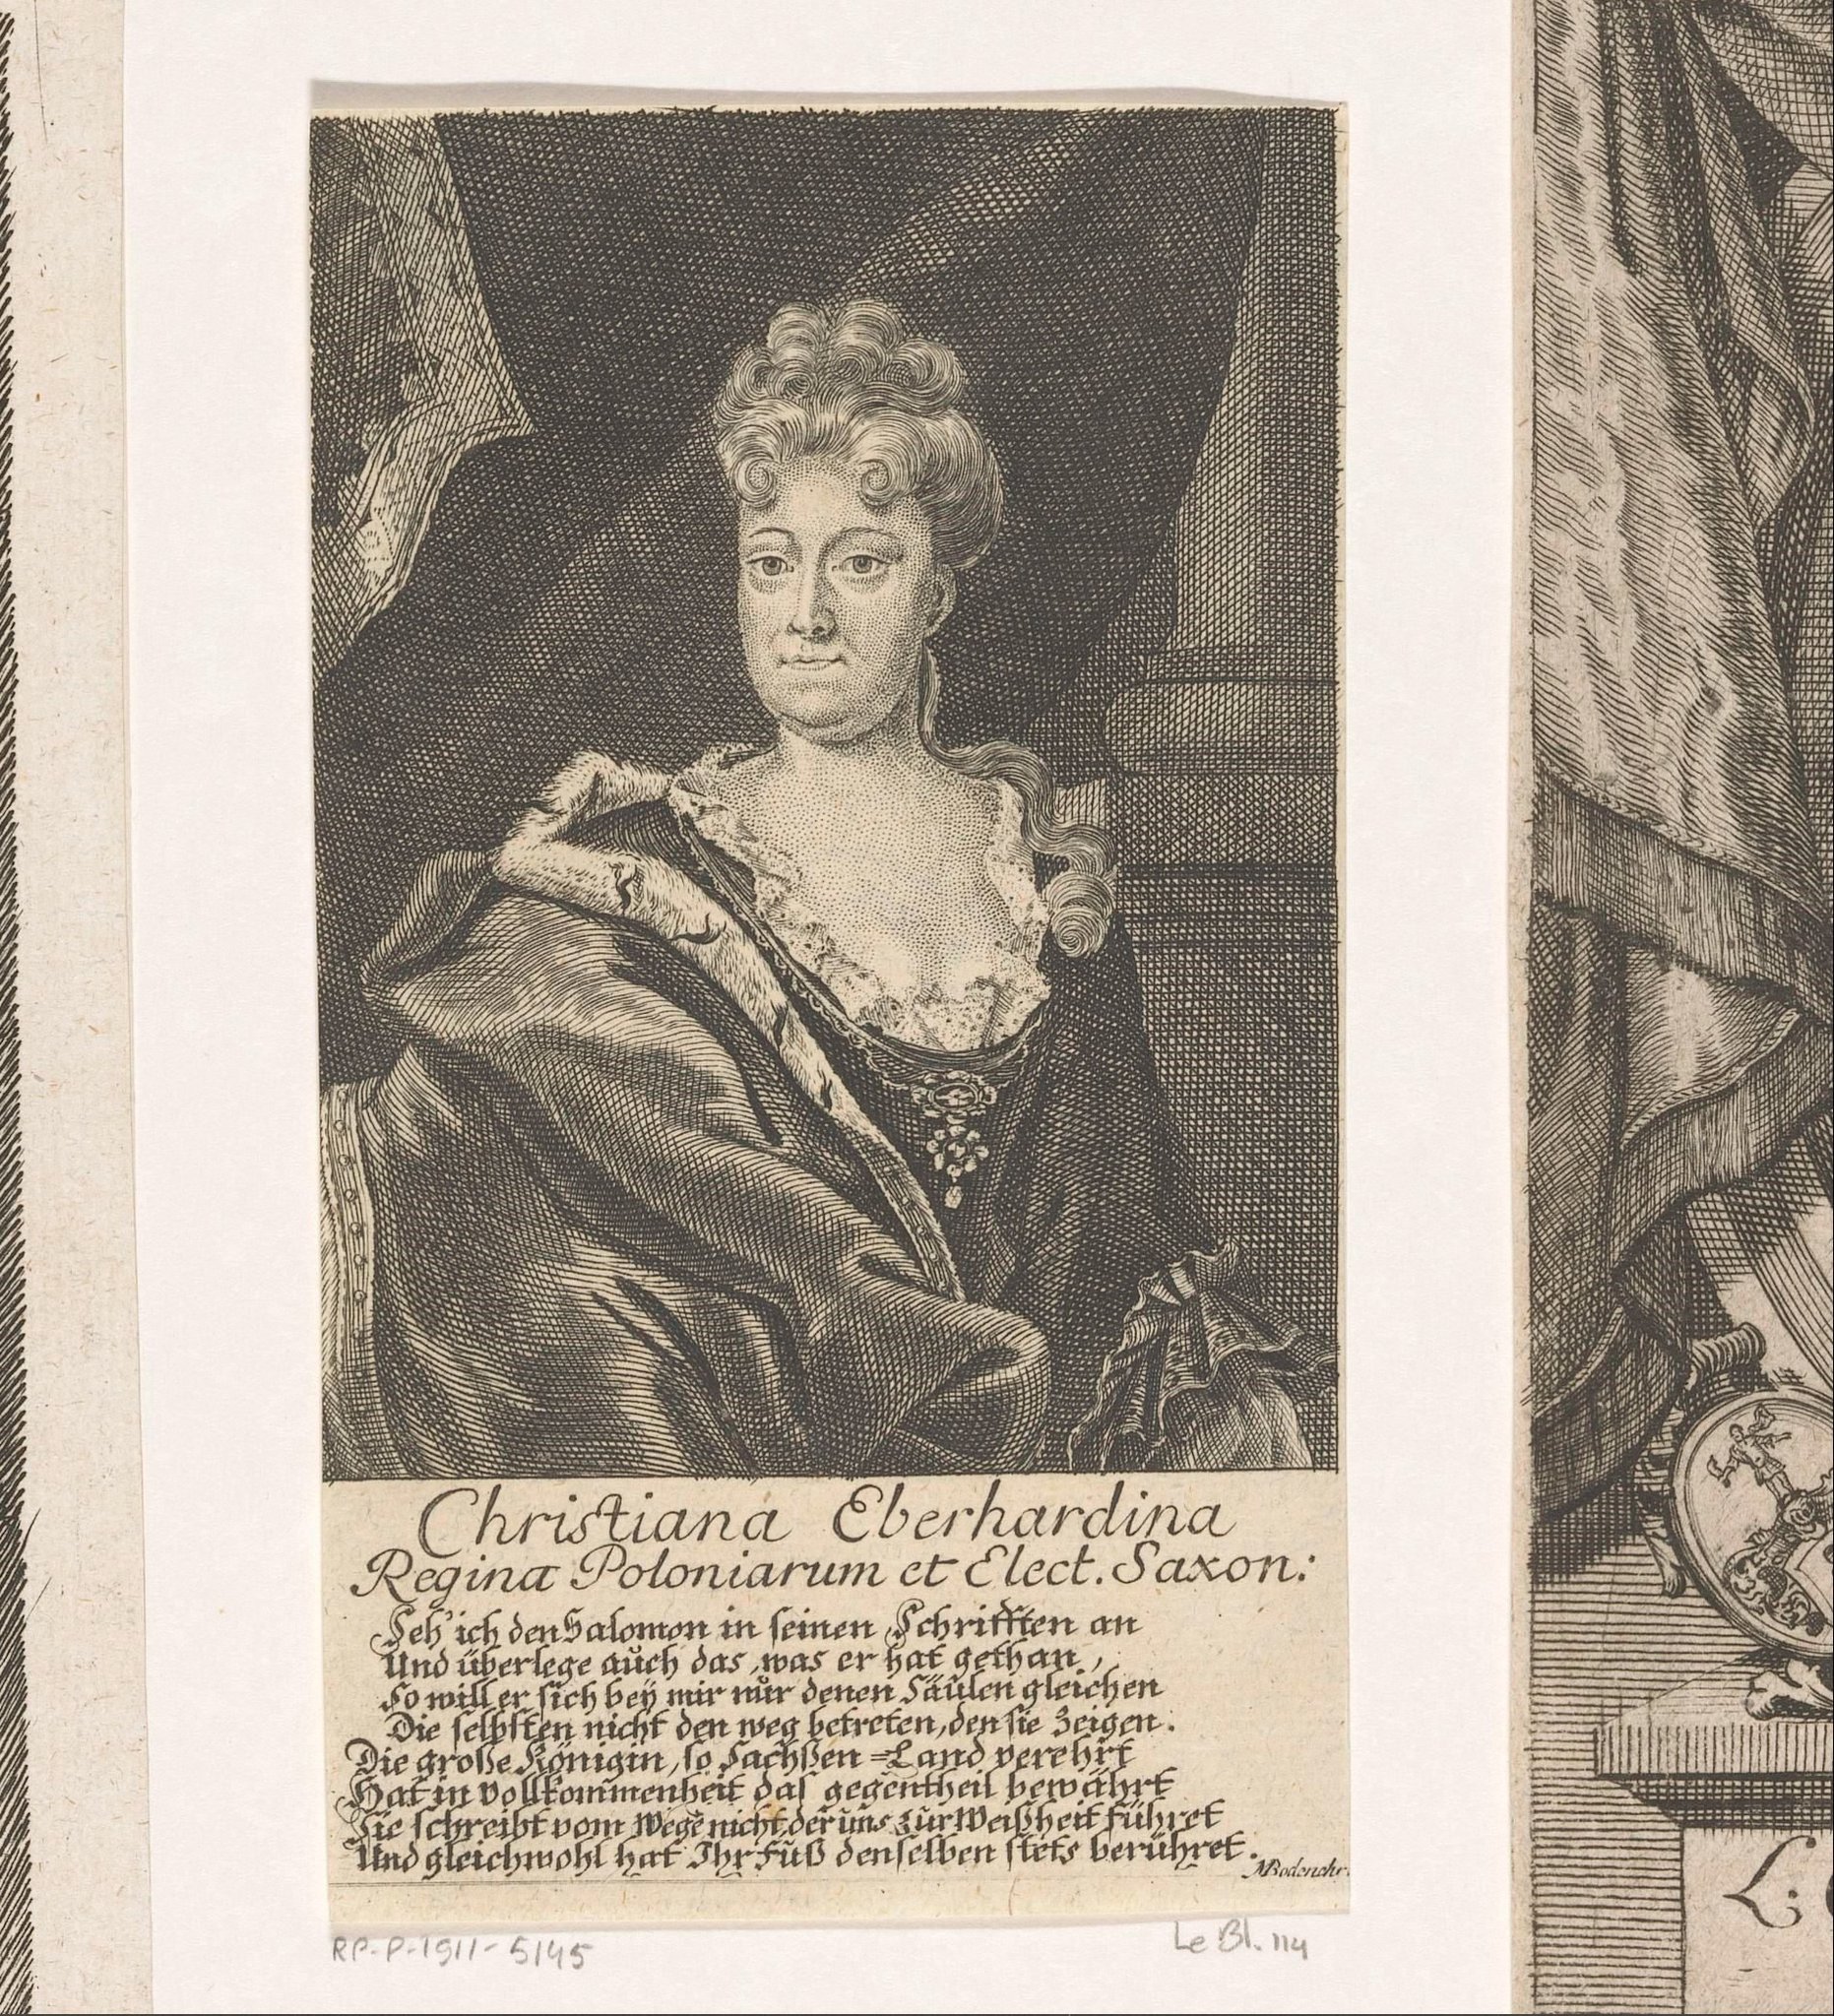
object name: print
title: Portret van Christiane Eberhardine van Brandenburg-Bayreuth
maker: moritz bodenehr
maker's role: print maker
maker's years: 1665-1749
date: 1697-1748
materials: paper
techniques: engraving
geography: dresden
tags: historical persons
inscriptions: collector's mark: Lugt 2228